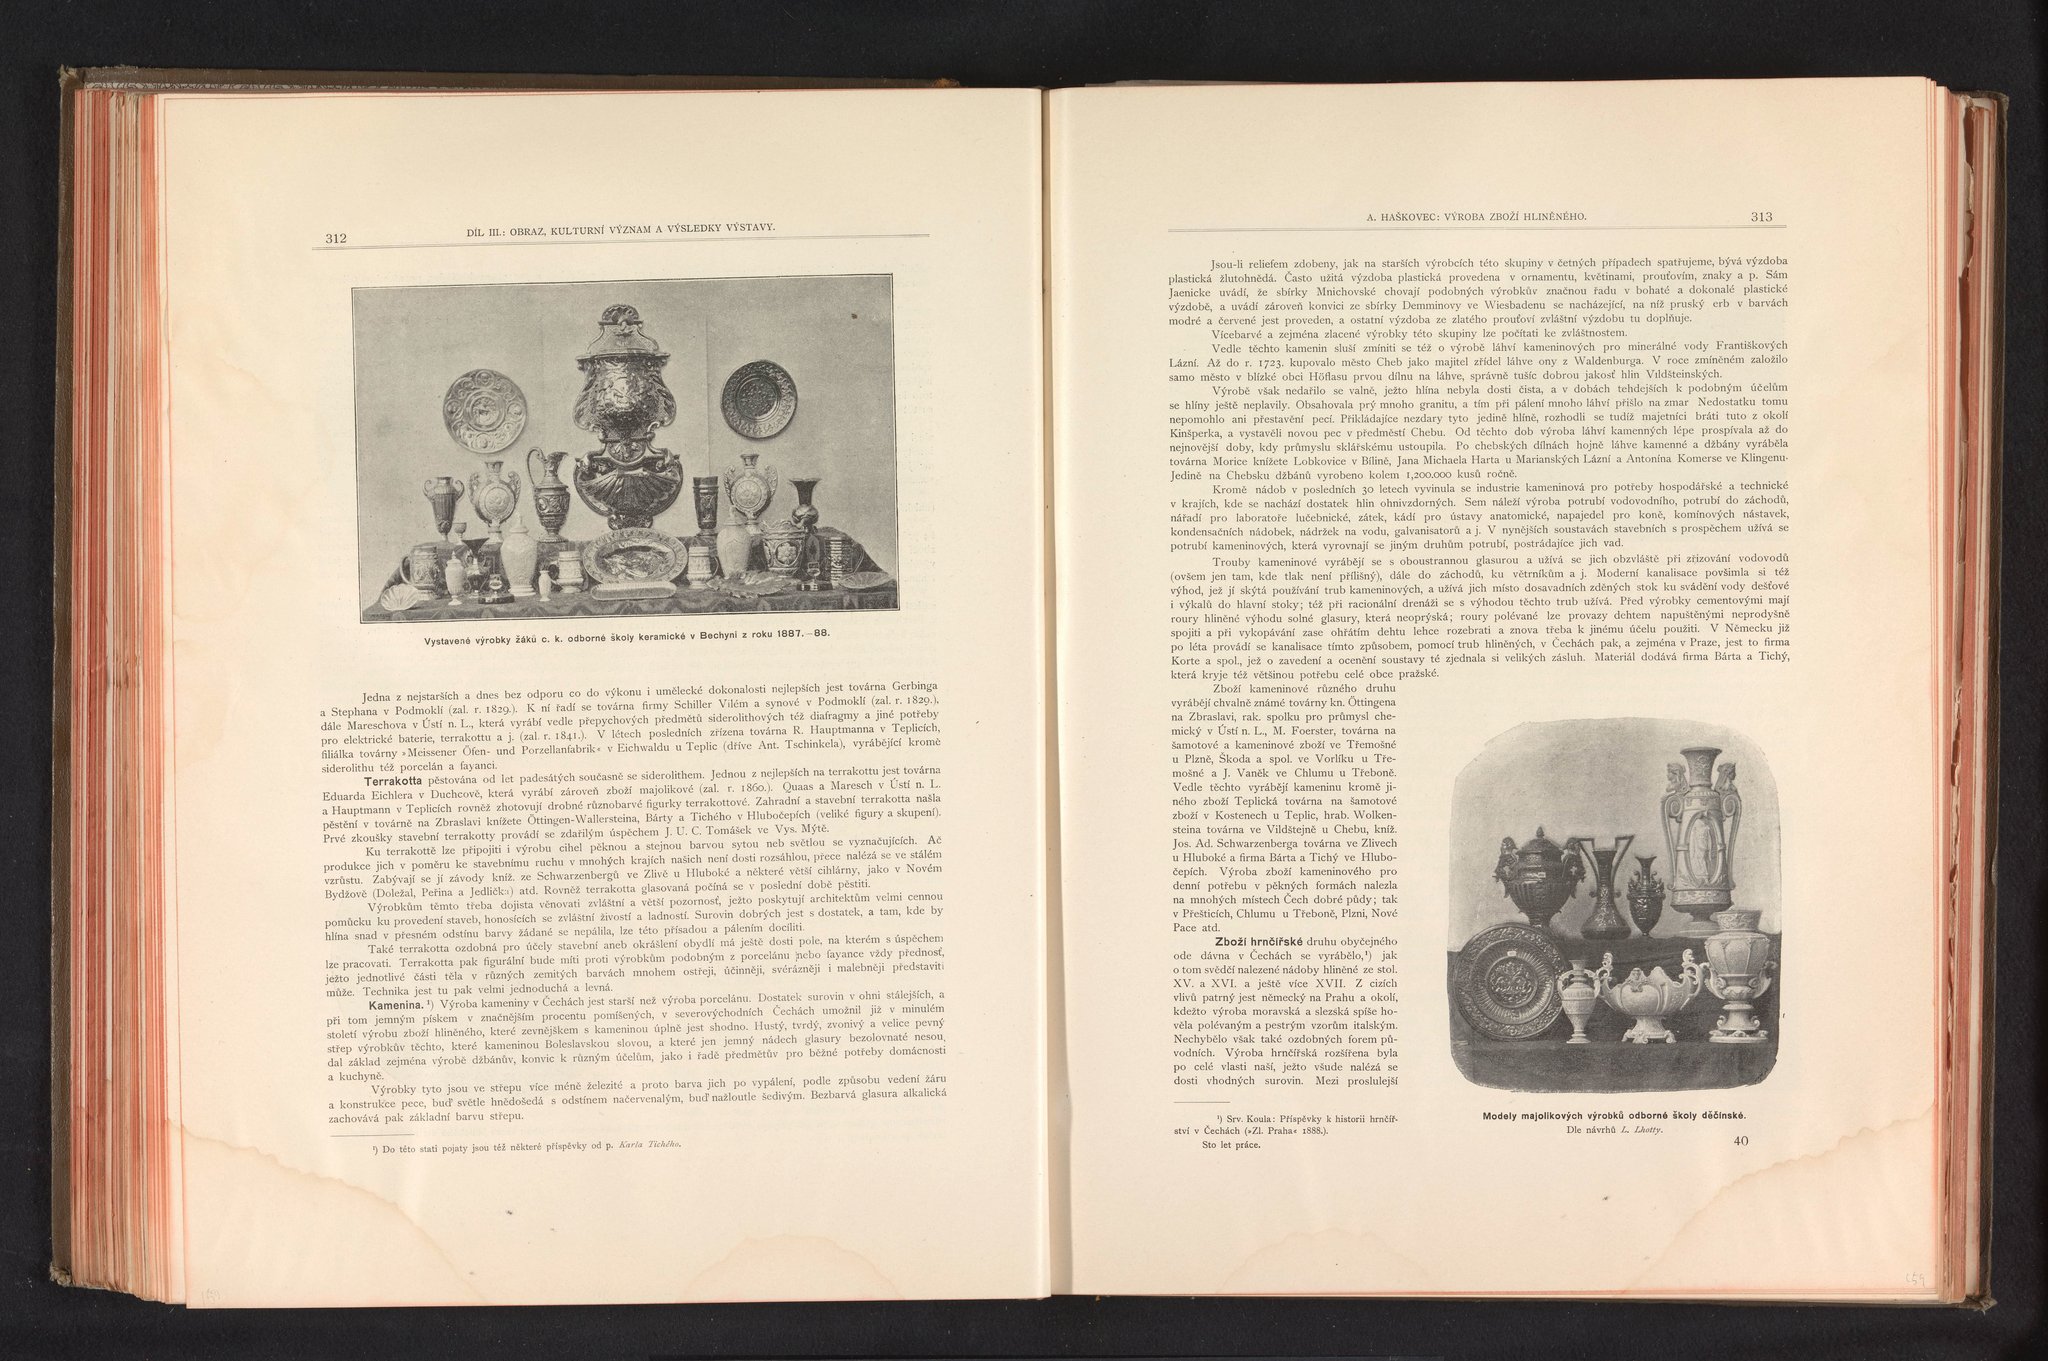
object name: page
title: Opstelling van modellen van de Vakschool voor Majolica te Děčín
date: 1890-1895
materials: paper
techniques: autotype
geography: prague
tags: container of ceramics: jar, jug, pot, vase